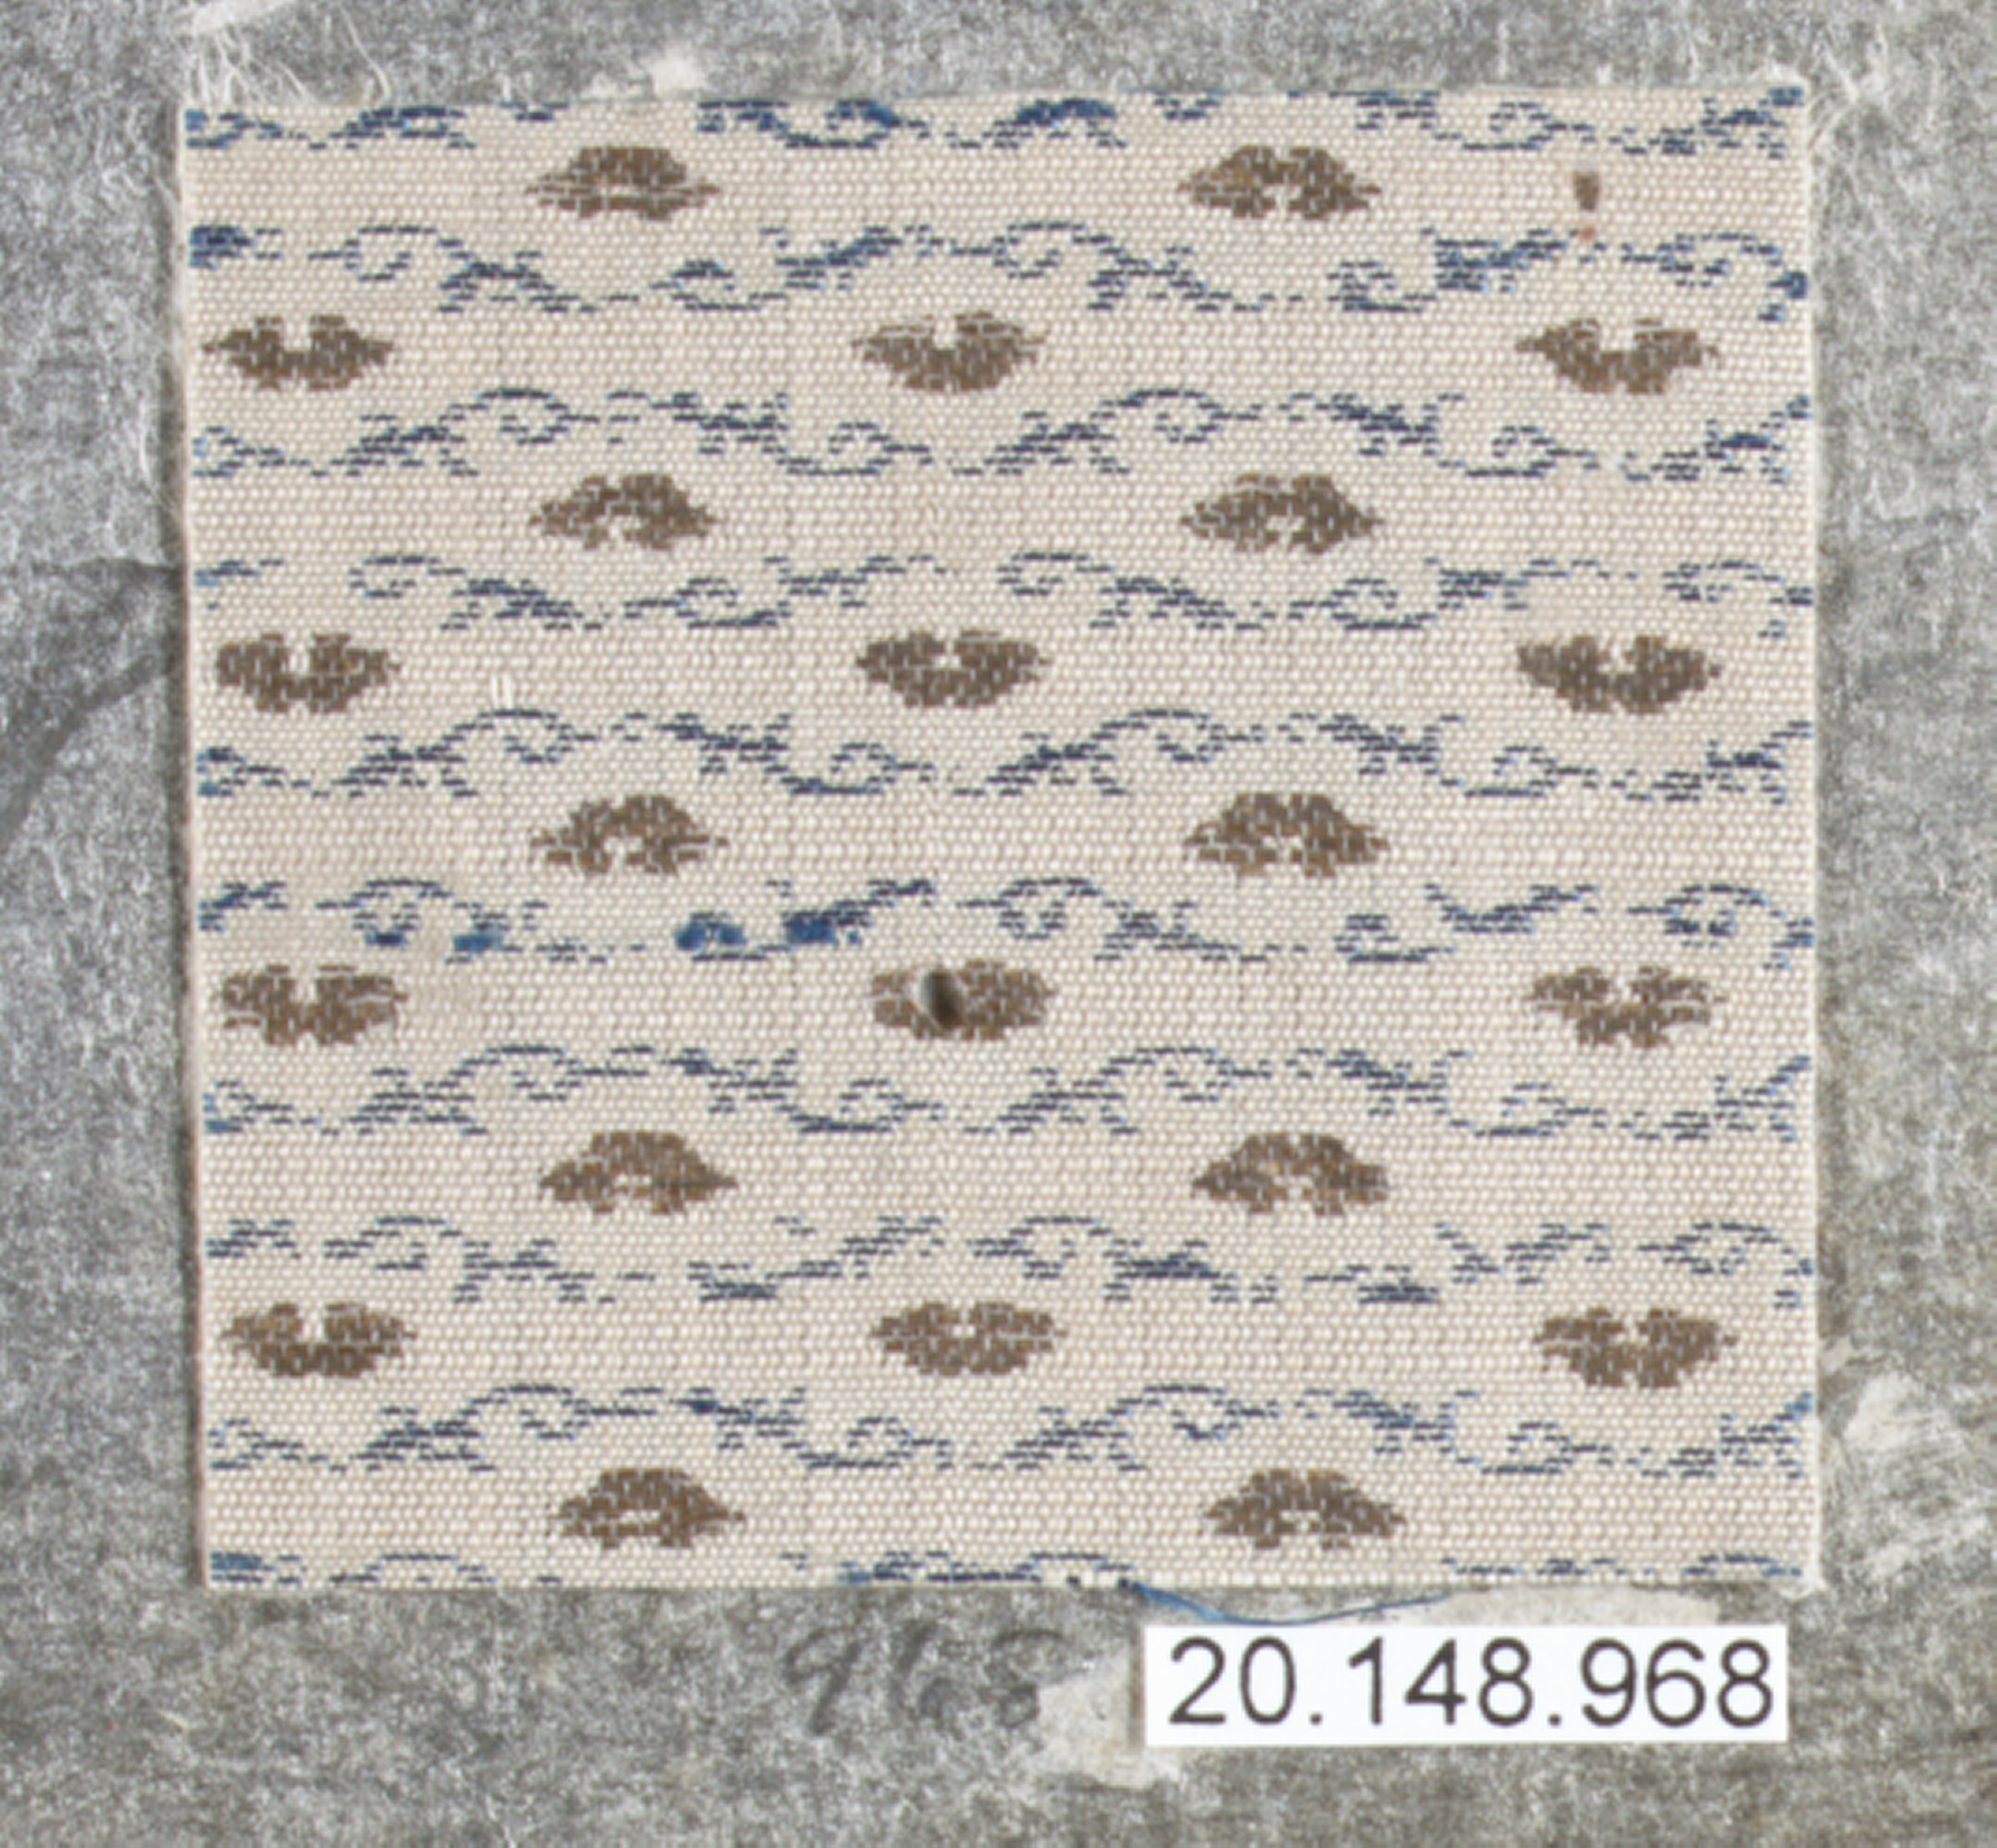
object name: piece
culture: japanese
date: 1701-1800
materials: silk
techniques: compound weave